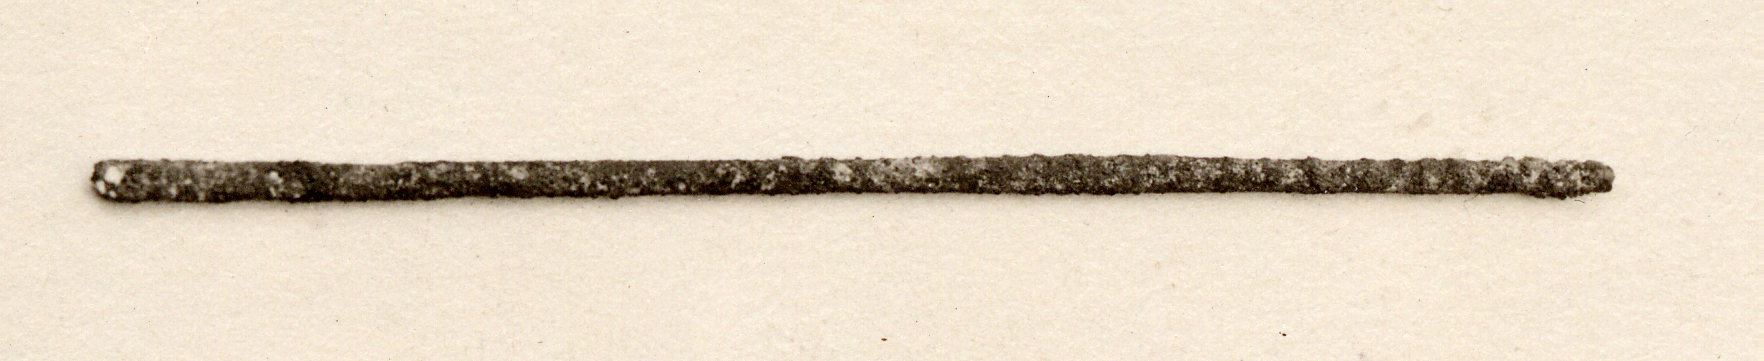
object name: wire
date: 1550-1458 BCE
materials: bronze, copper alloy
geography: egypt